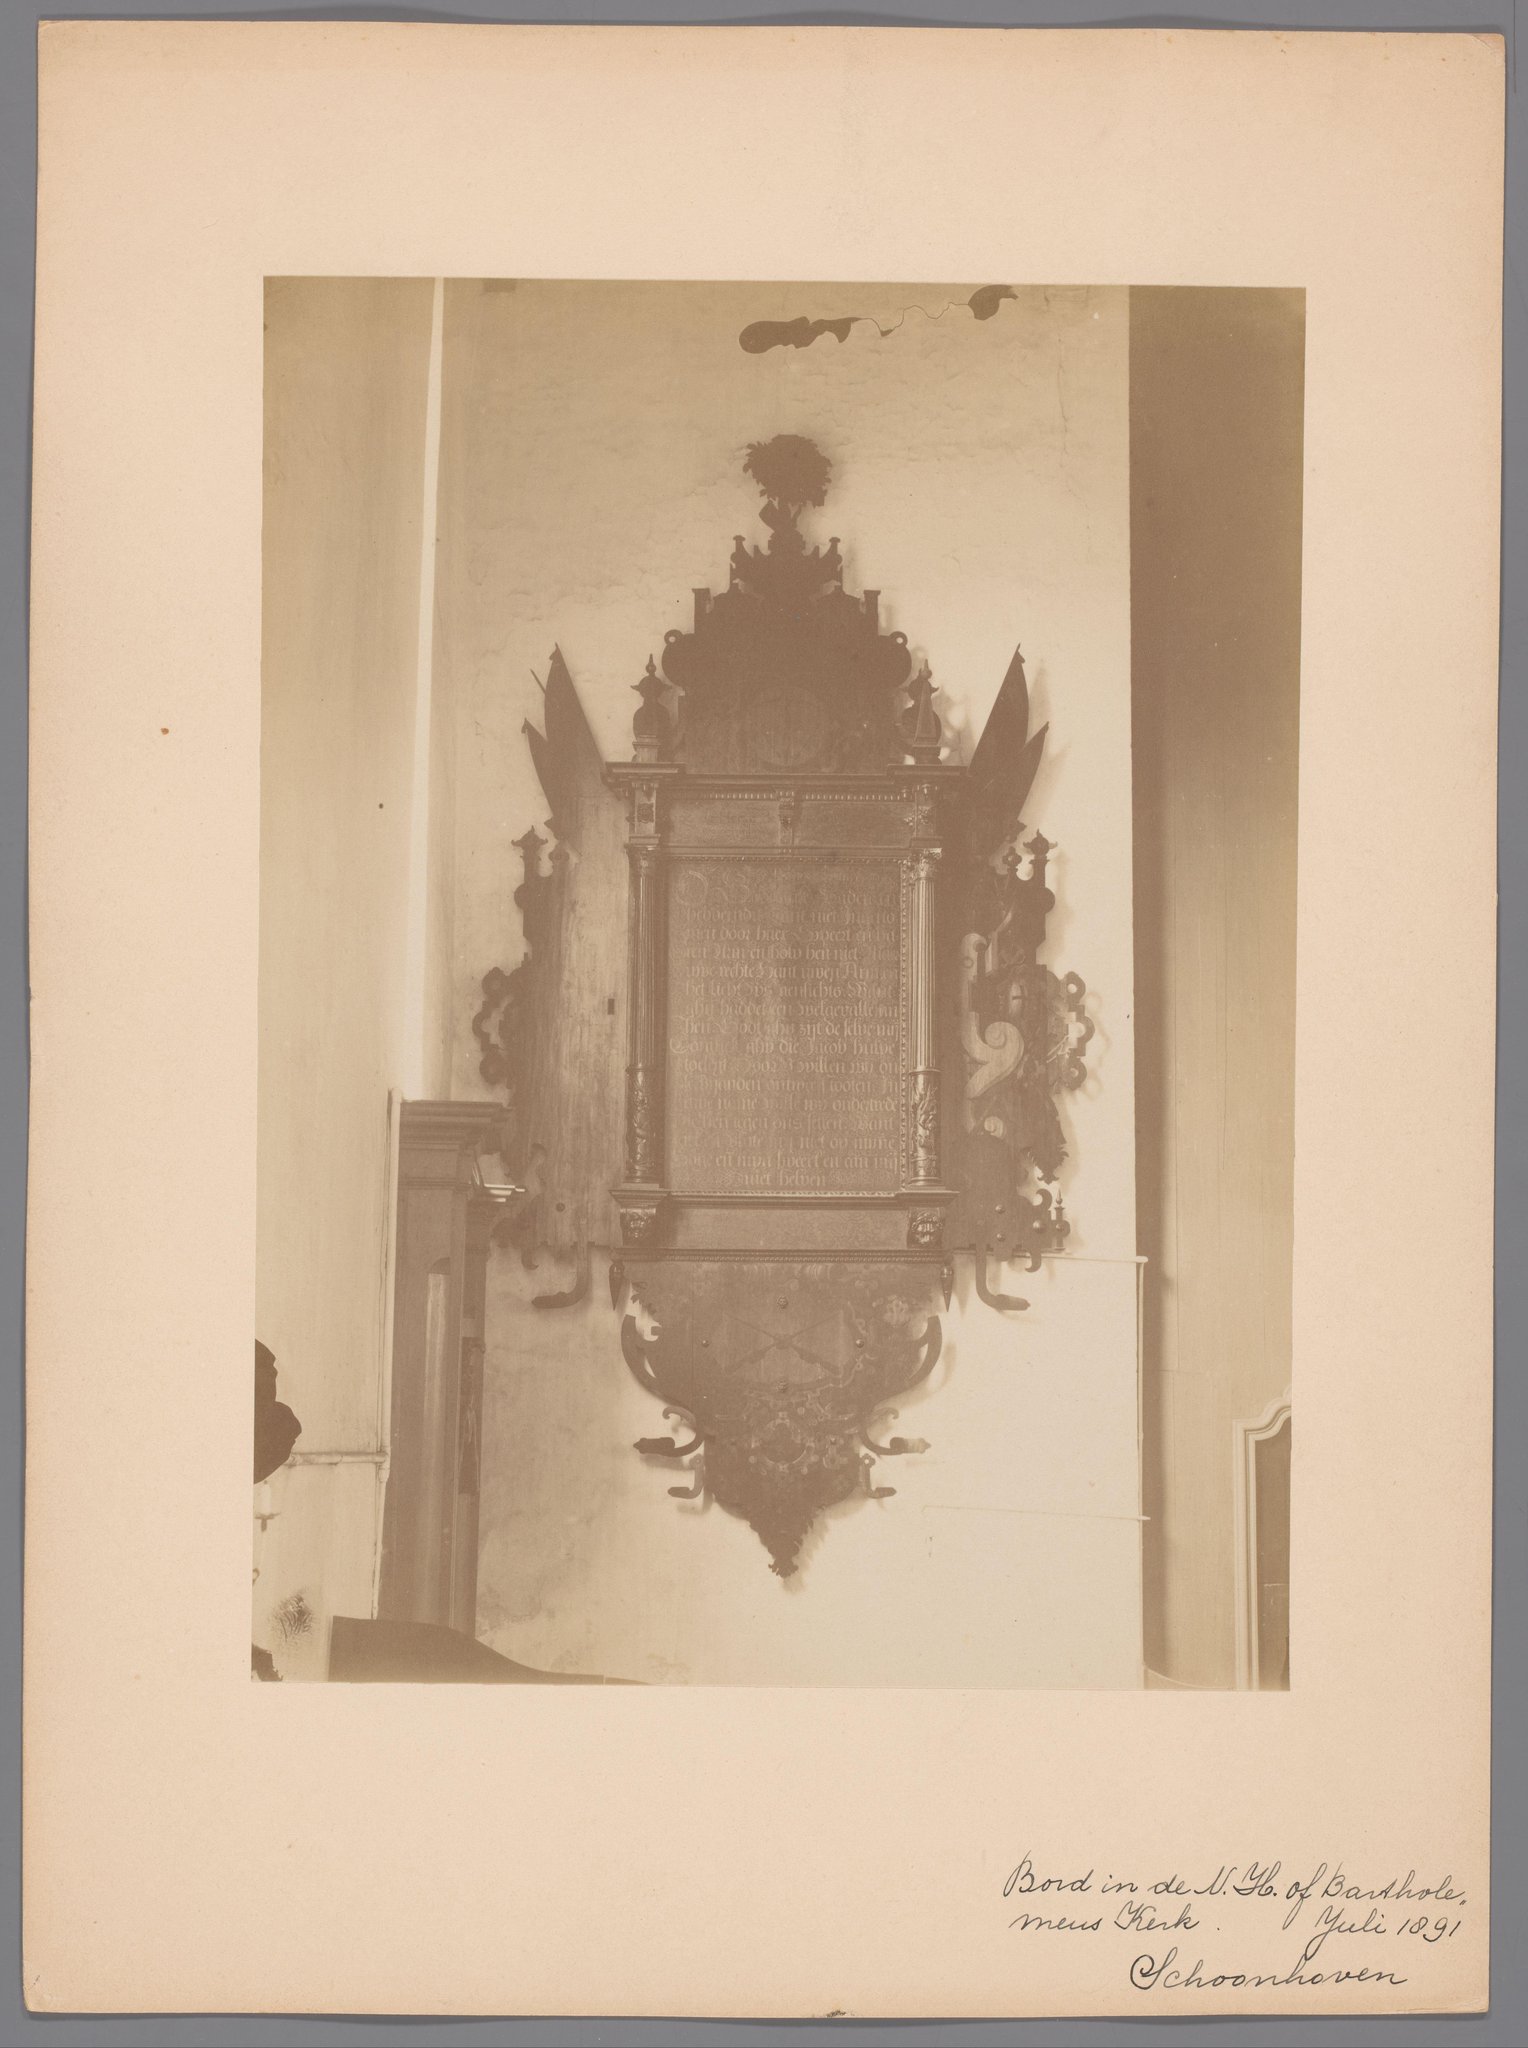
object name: photograph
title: Bord in de Grote of Bartholomeüskerk te Schoonhoven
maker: anoniem (monumentenzorg)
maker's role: fotograaf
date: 1891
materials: cardboard, photographic support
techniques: albumen print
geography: grote of bartholomeüskerk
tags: parts of church interior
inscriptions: annotation: ‘Bord in de N.H. of Bartholemeus Kerk/ Juli 1891/ Schoonhoven’, annotation: ‘Schoonhoven/ Bord in de N.H. Kerk/ Juli 1891’